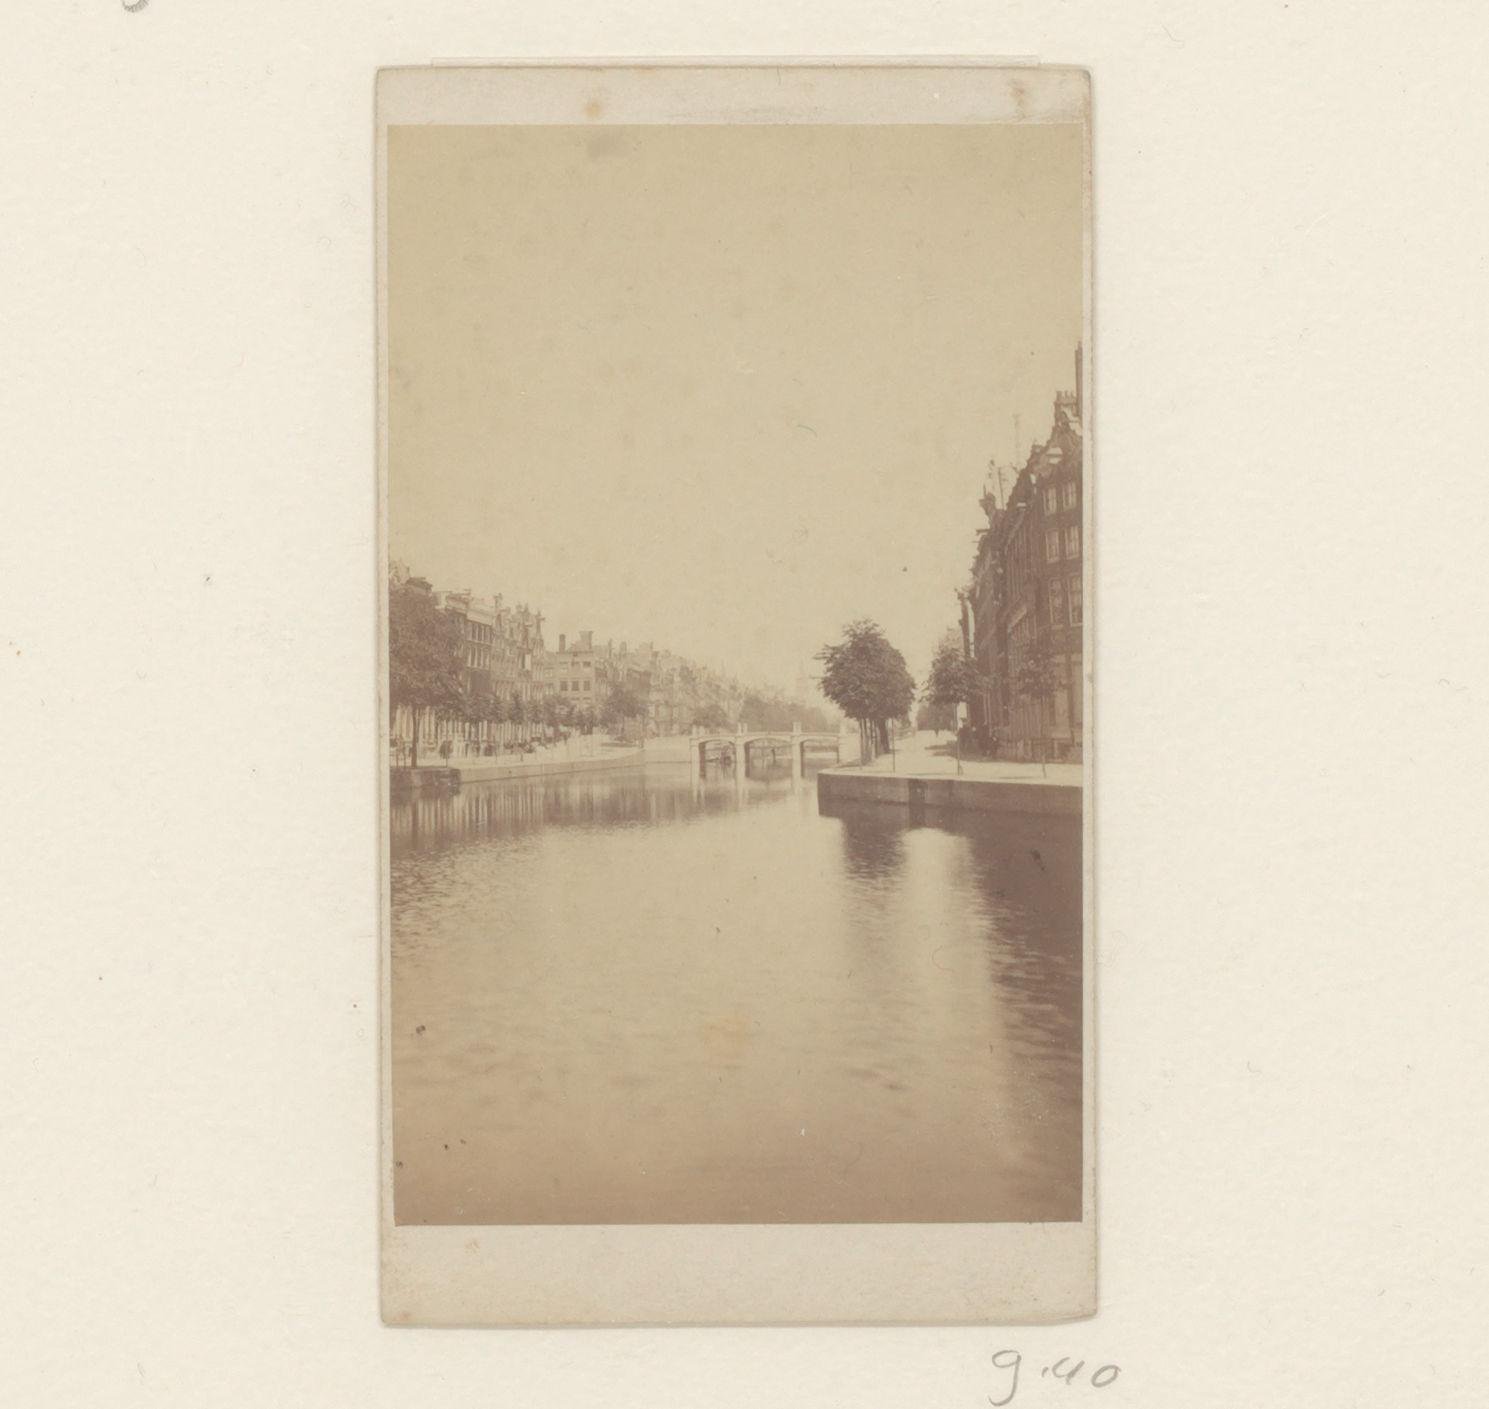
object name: carte de visite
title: Gezicht op de Keizersgracht bij de Leliegracht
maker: andries jager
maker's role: publisher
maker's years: 1825-1905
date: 1849-1885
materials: cardboard, paper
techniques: albumen print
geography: amsterdam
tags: city-view in general; 'veduta', canal, bridge in city across river, canal, etc.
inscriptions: inscription: ‘72. De Keizersgracht bij de Leliegracht.’, stamp: ‘A. Jager / Water, 110 / Amsterdam’, collector's mark: ‘9,40’ Lugt 1641b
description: Onderwerpsrubriek binnen de Atlas Amsterdam: Kadijksplein, Karthuizerkerkhof, Kattegat, Kattenburg, Kapelsteeg O.Z., Enge Kerksteeg, Kerkstraat, Kinkerstraat, Kolk O.Z., Koningsplein, Kromboomsloot [Krom Boomssloot], Kostverlorenkade, Kwakersdwarspad, Kalverstraat, Keizersgracht (v.d. Brouwersgracht – Amstel), Klerensloot (Gedempte), Klimopstraat, Kloveniersburgwal, Kraansluis.